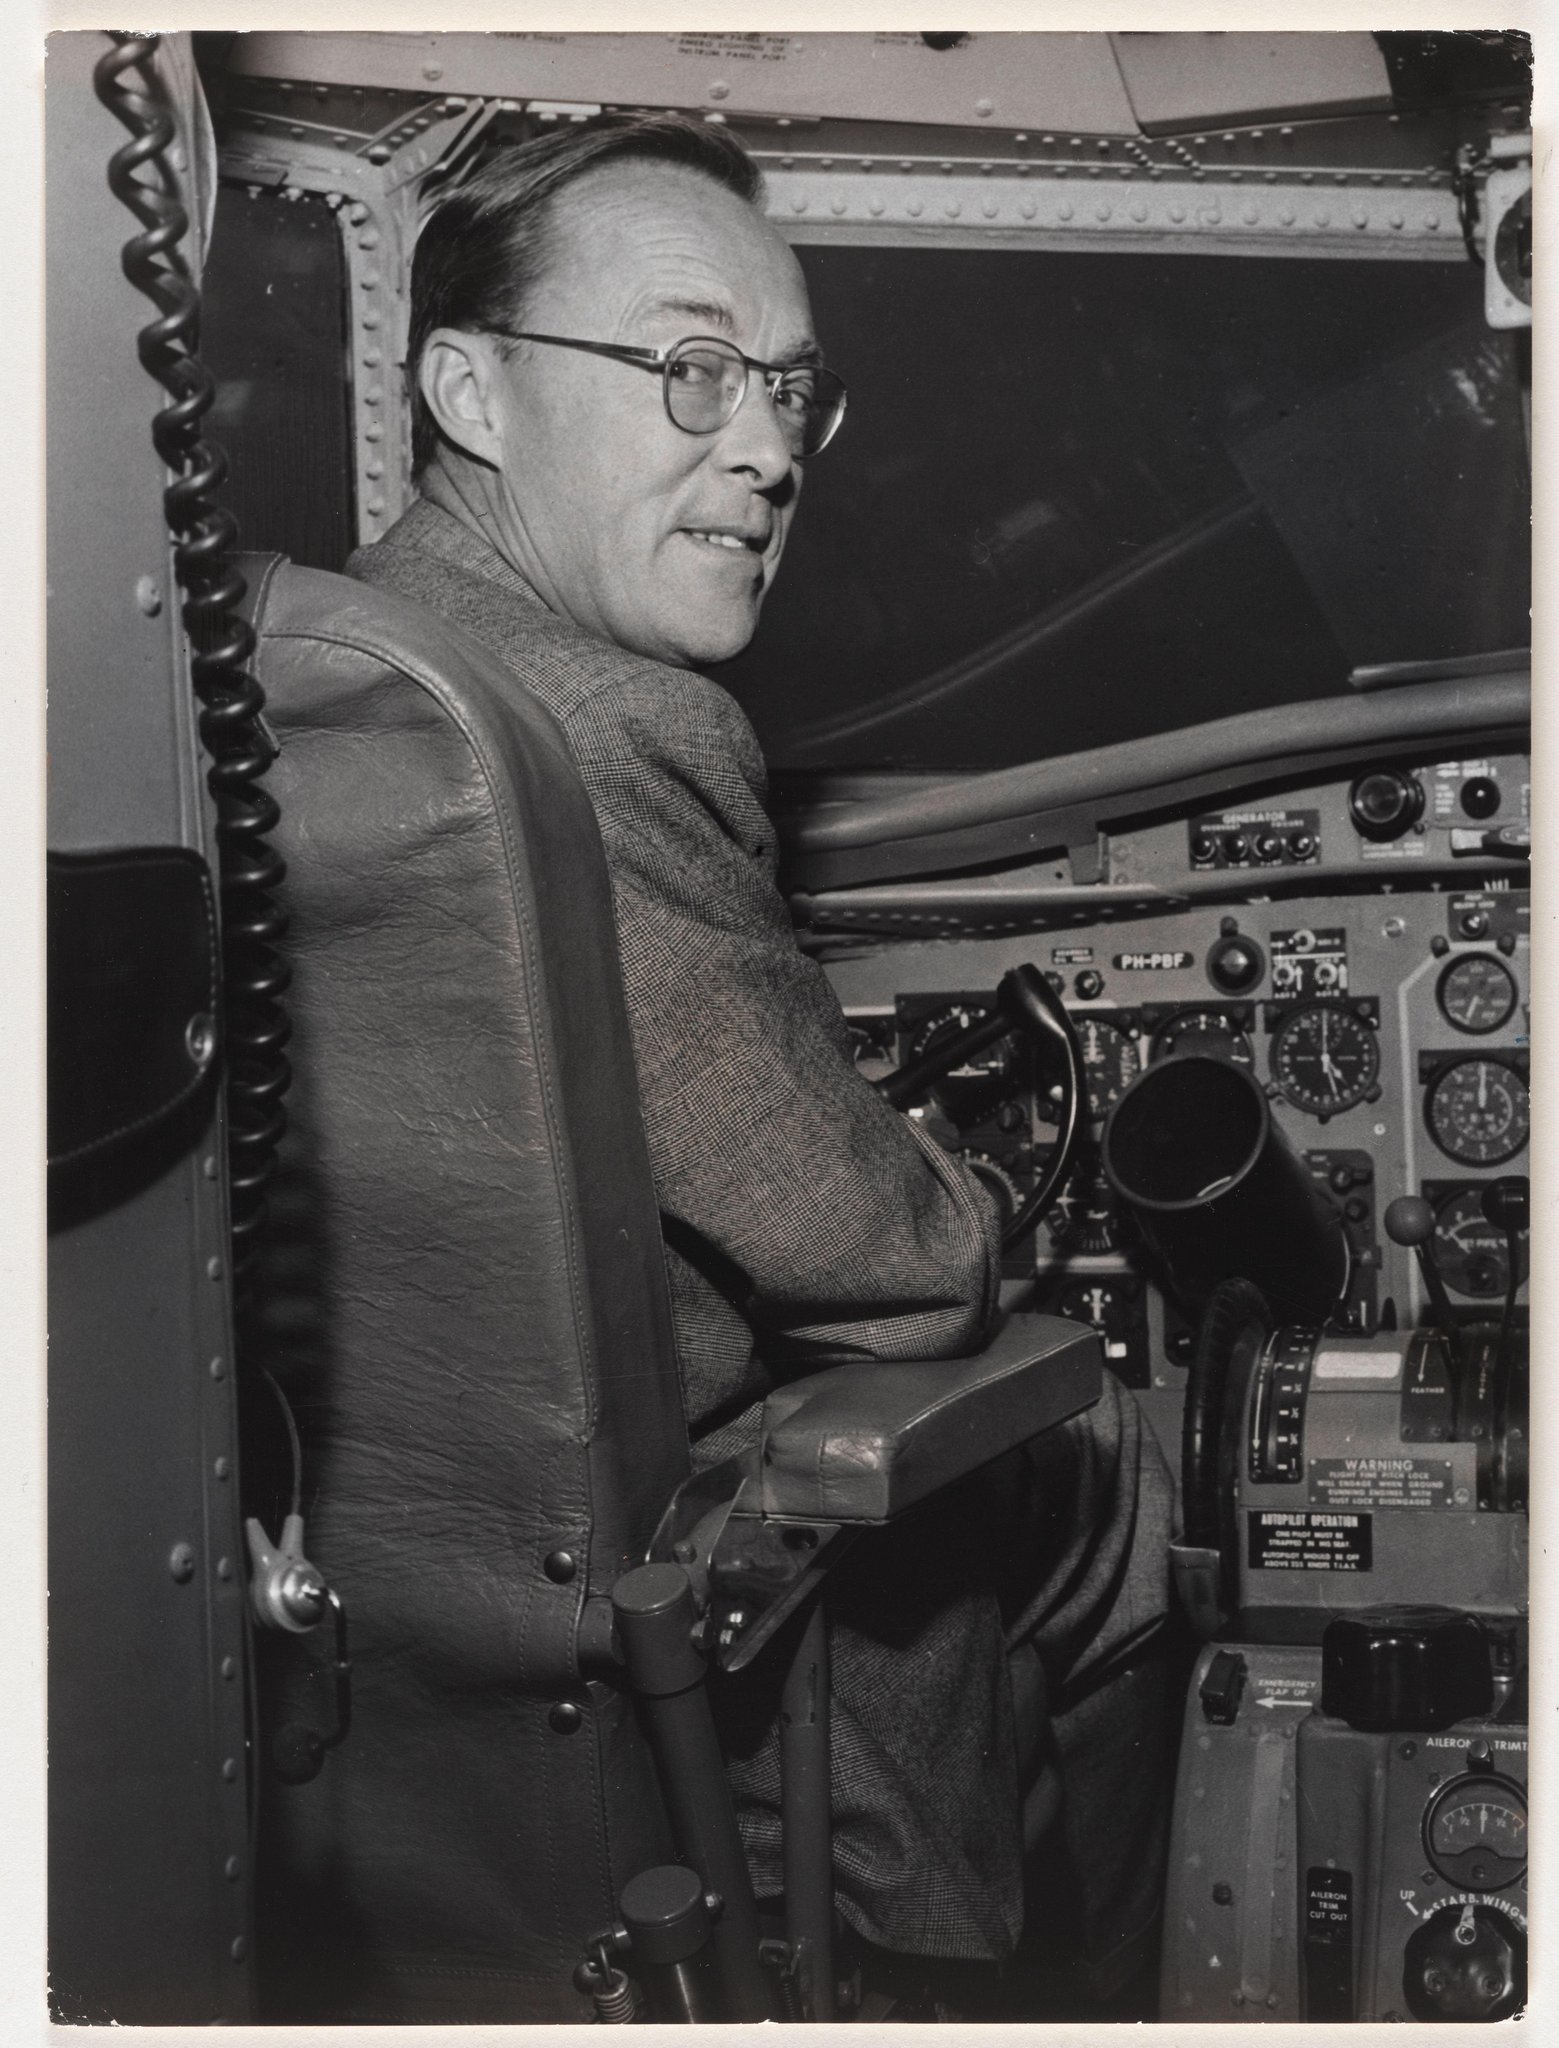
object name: photograph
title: Prince Bernhard the Pilot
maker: w. månsson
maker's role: fotograaf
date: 1960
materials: photographic support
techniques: gelatin silver print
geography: denmark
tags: utrecht, bernhard (prins der nederlanden)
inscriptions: stamp, label: ‘Prince Bernhard.....The Pilot. During his visit to Denmark as president of the European Cultural Foundation Prince Bernhard flew his own plane, a new plane his [sic] has just got a Few weeks ago. Earlier he had a DC-3, but now he is flying a Dutch Fokker Friendship etc..........’